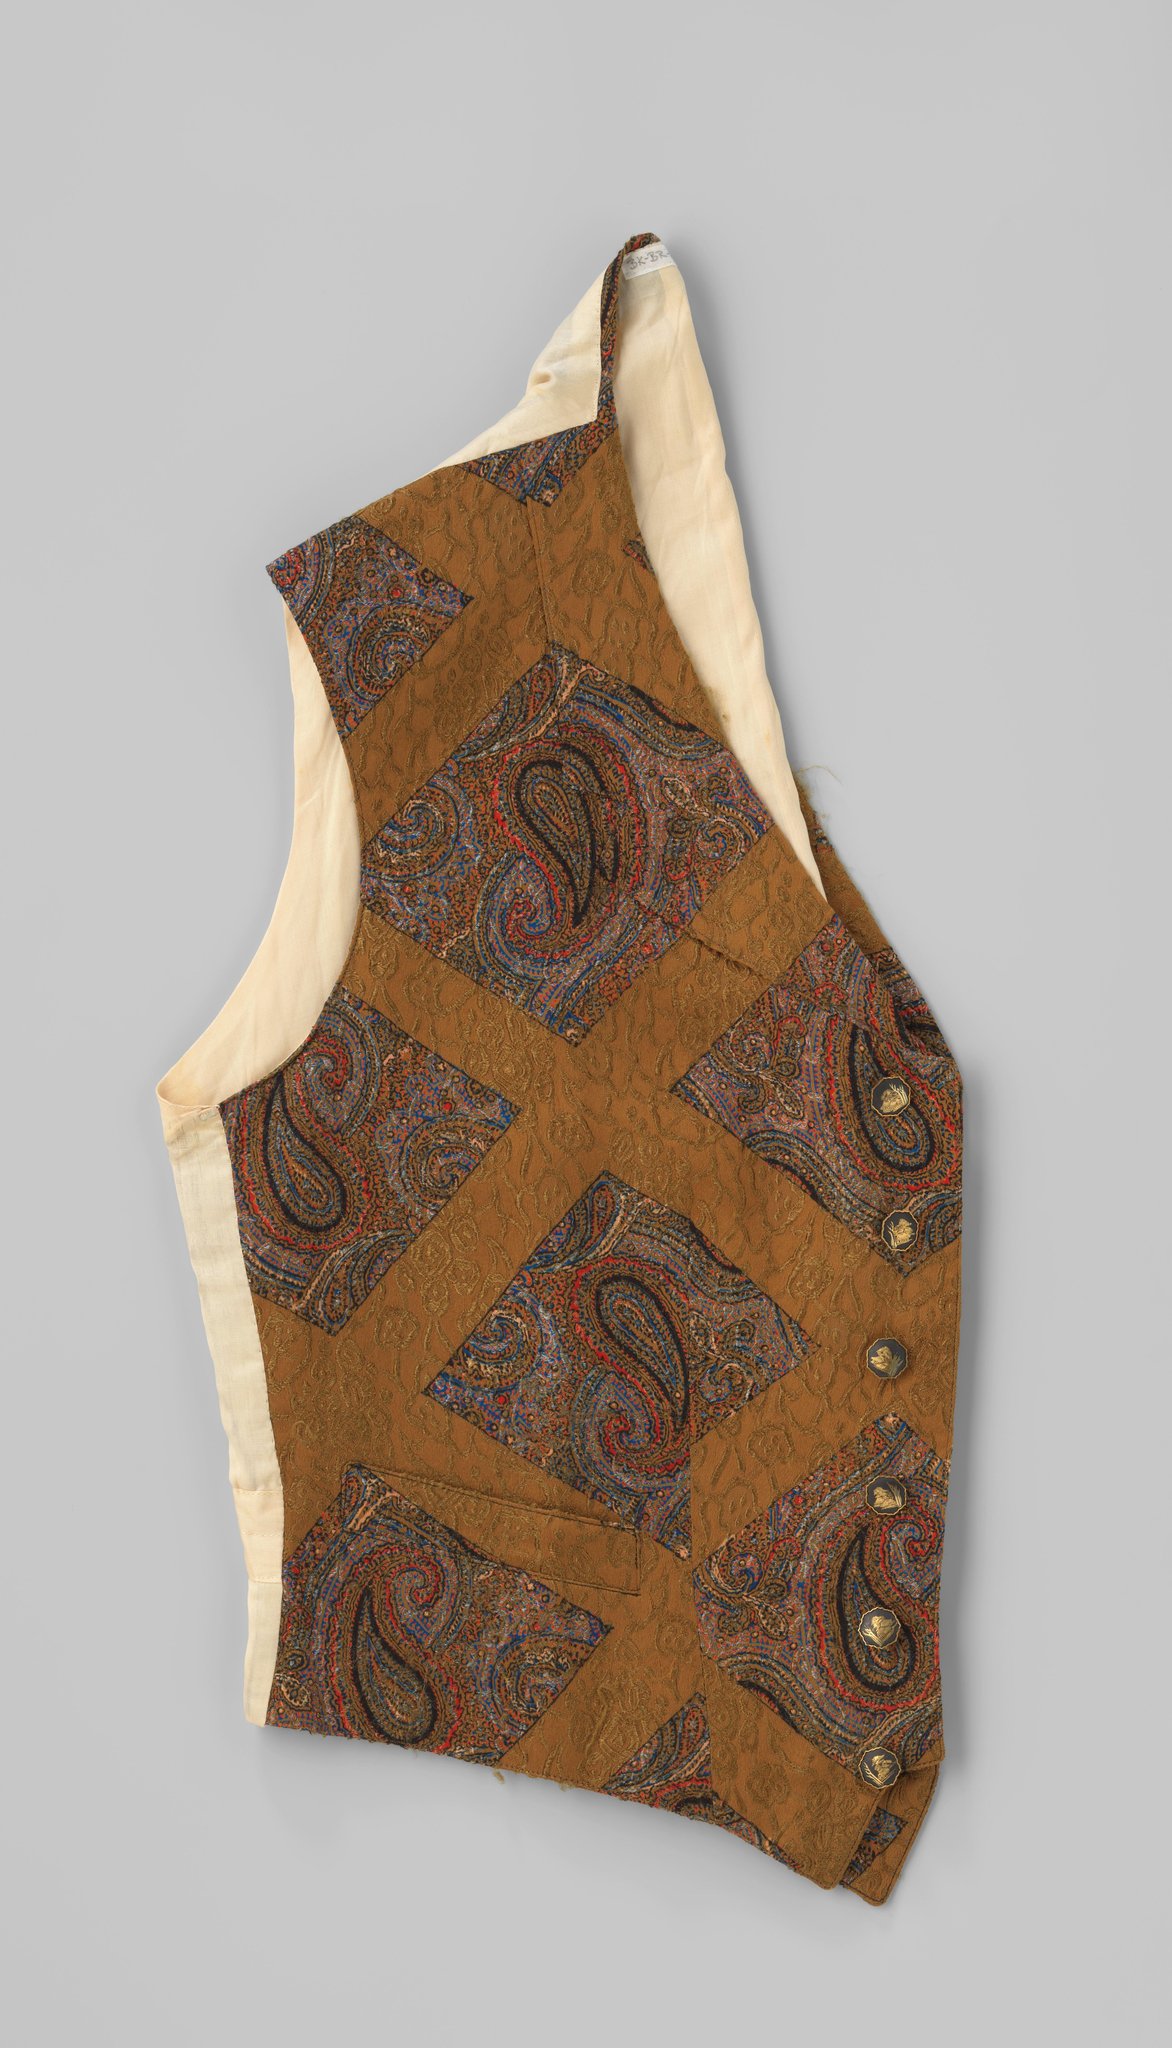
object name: waistcoat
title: Vest met drie zakken, 6 zwarte knopen met goud oosters tafereel en revers van geelbruine wol met ingeweven bloem- en bladmotief en gekleurd paislymotief binnen vierkanten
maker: Anonymous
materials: cotton, wool